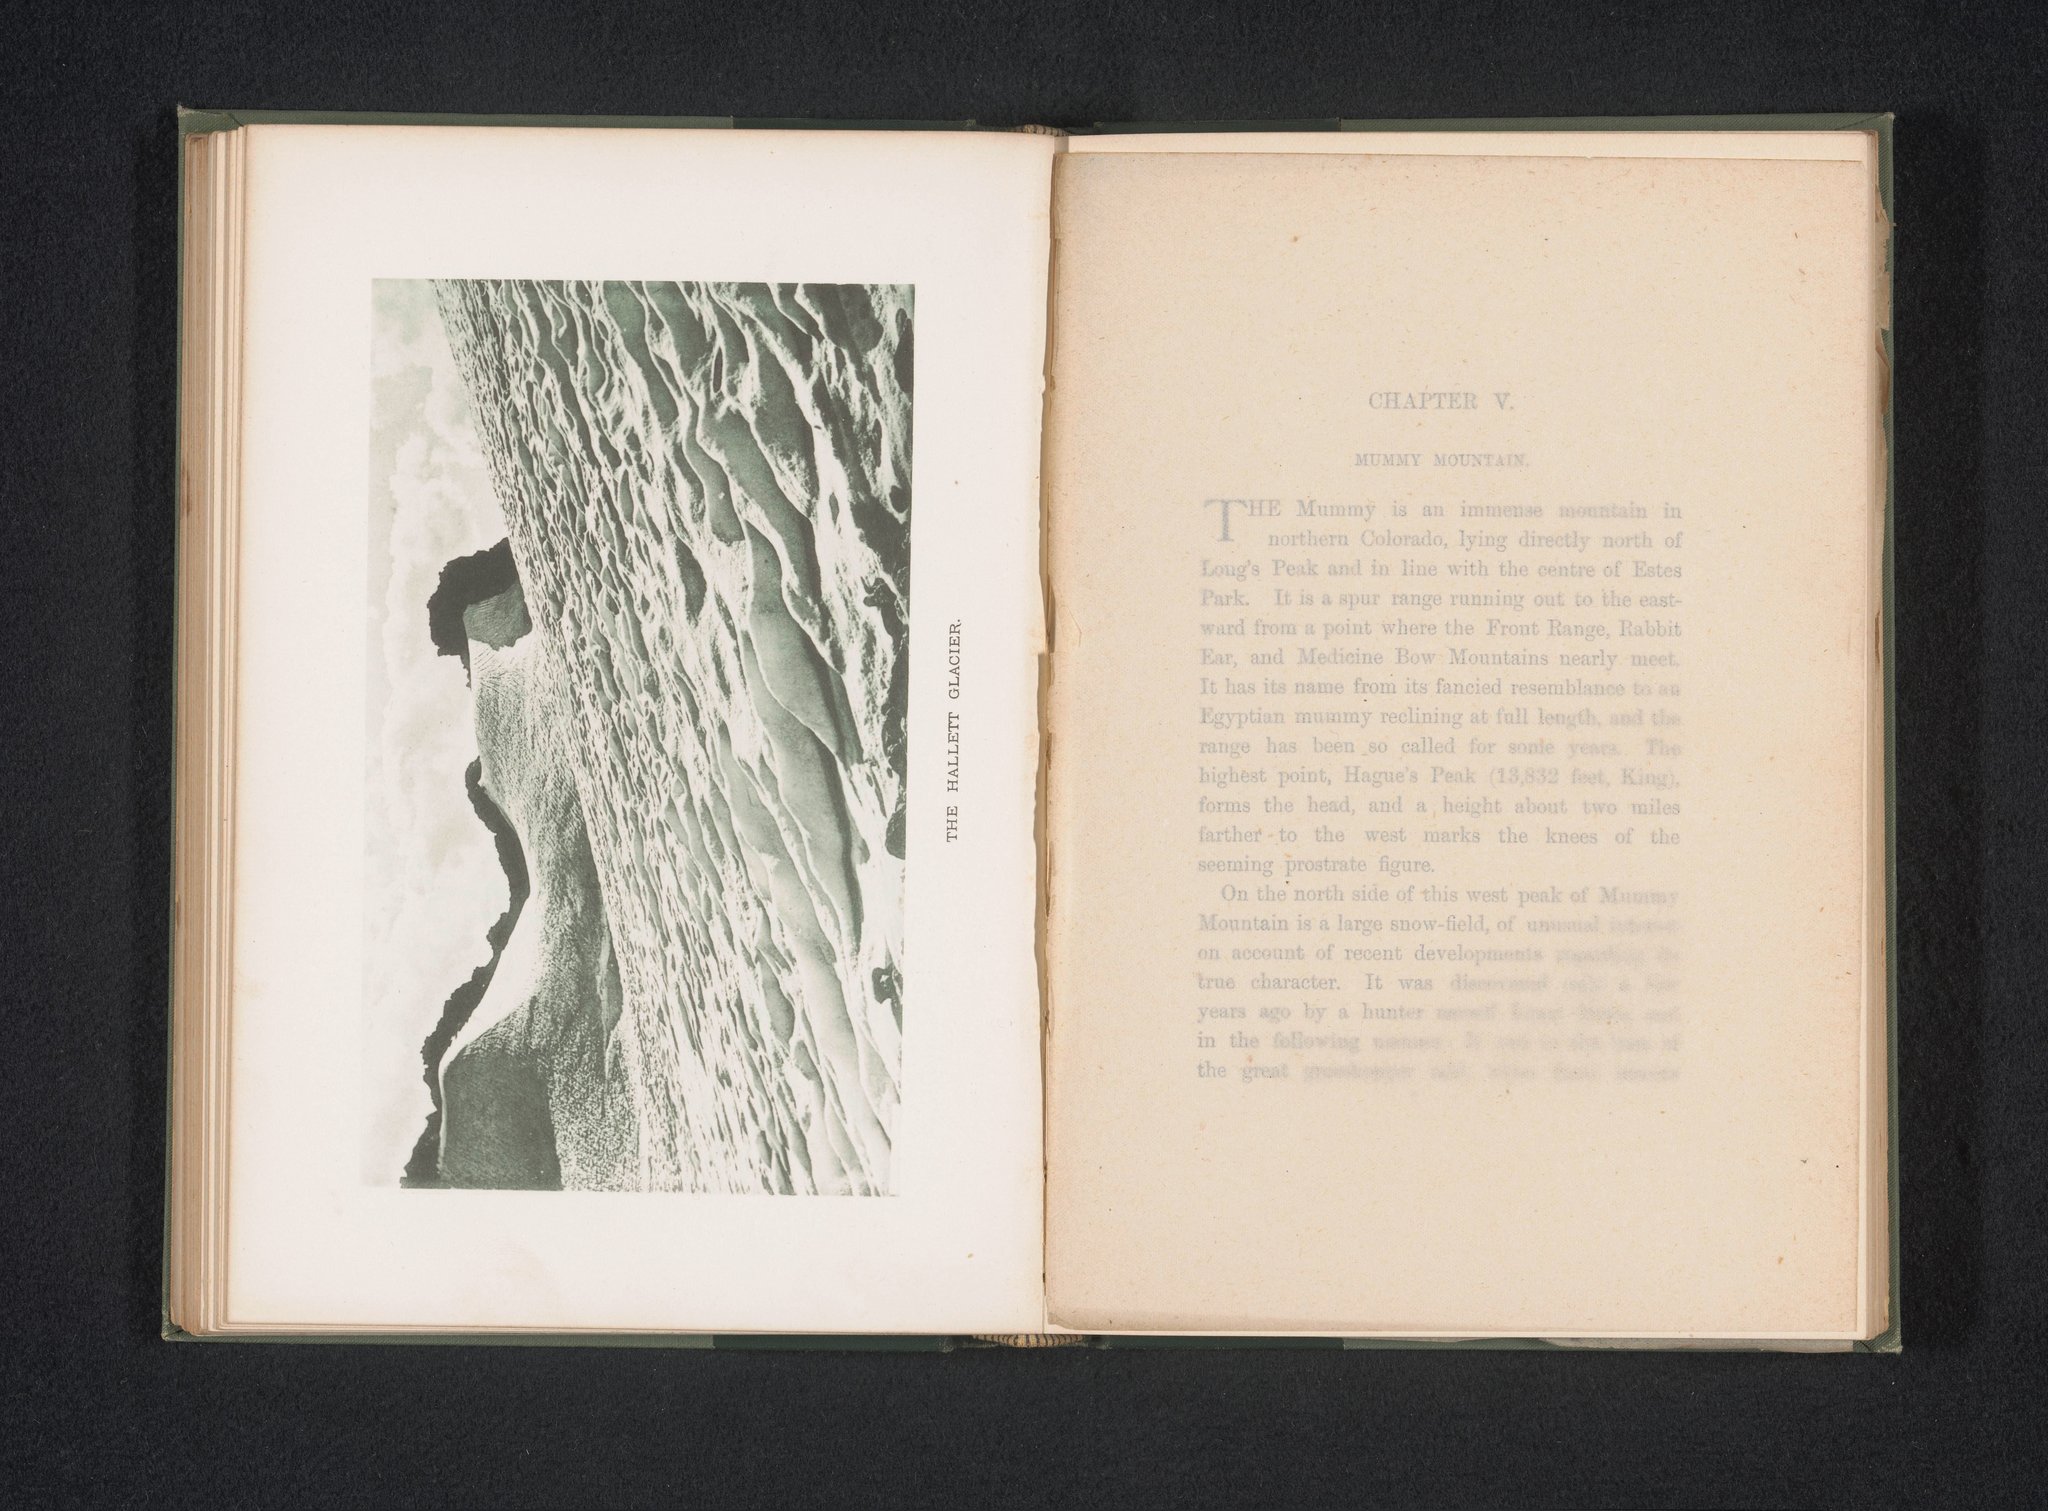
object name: photomechanical print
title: Gezicht op de gletsjer van Hallett Peak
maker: frederick hastings chapin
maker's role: antropoloog, archeoloog, fotograaf, schrijver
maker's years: 1852-1900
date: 1885-1890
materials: paper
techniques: photograph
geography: boston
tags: landscapes, glacier, mountains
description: Prent op tweede ongenummerde pagina na pagina 96.